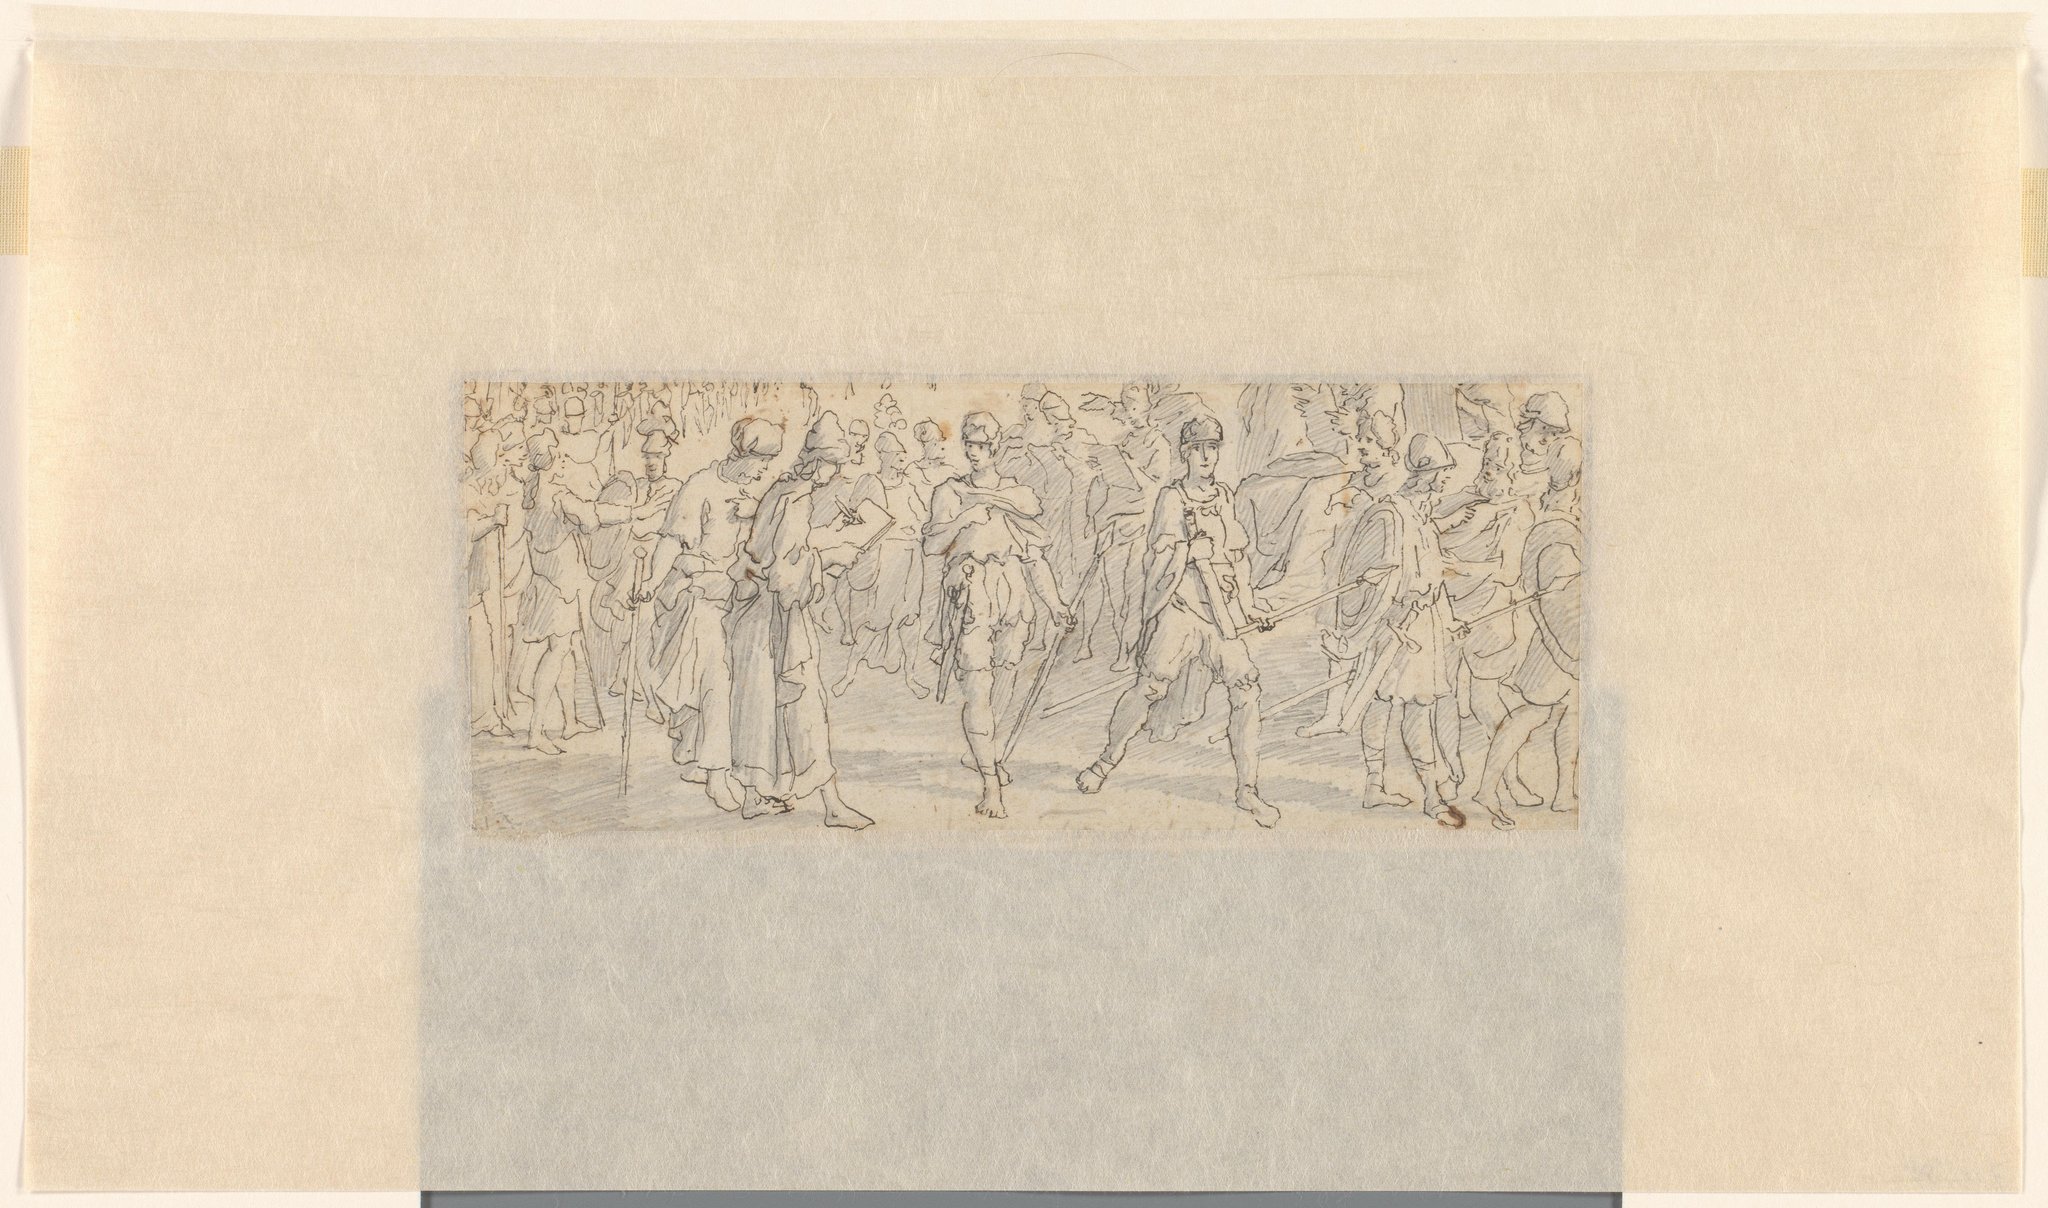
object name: drawing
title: Romeinse soldaten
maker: Anonymous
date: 1600-1699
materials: graphite, ink, paper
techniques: pen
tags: male persons from classical history, the soldier; the soldier's life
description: Romeinse soldaten (de doorgetrokken contouren van de recto-voorstelling).